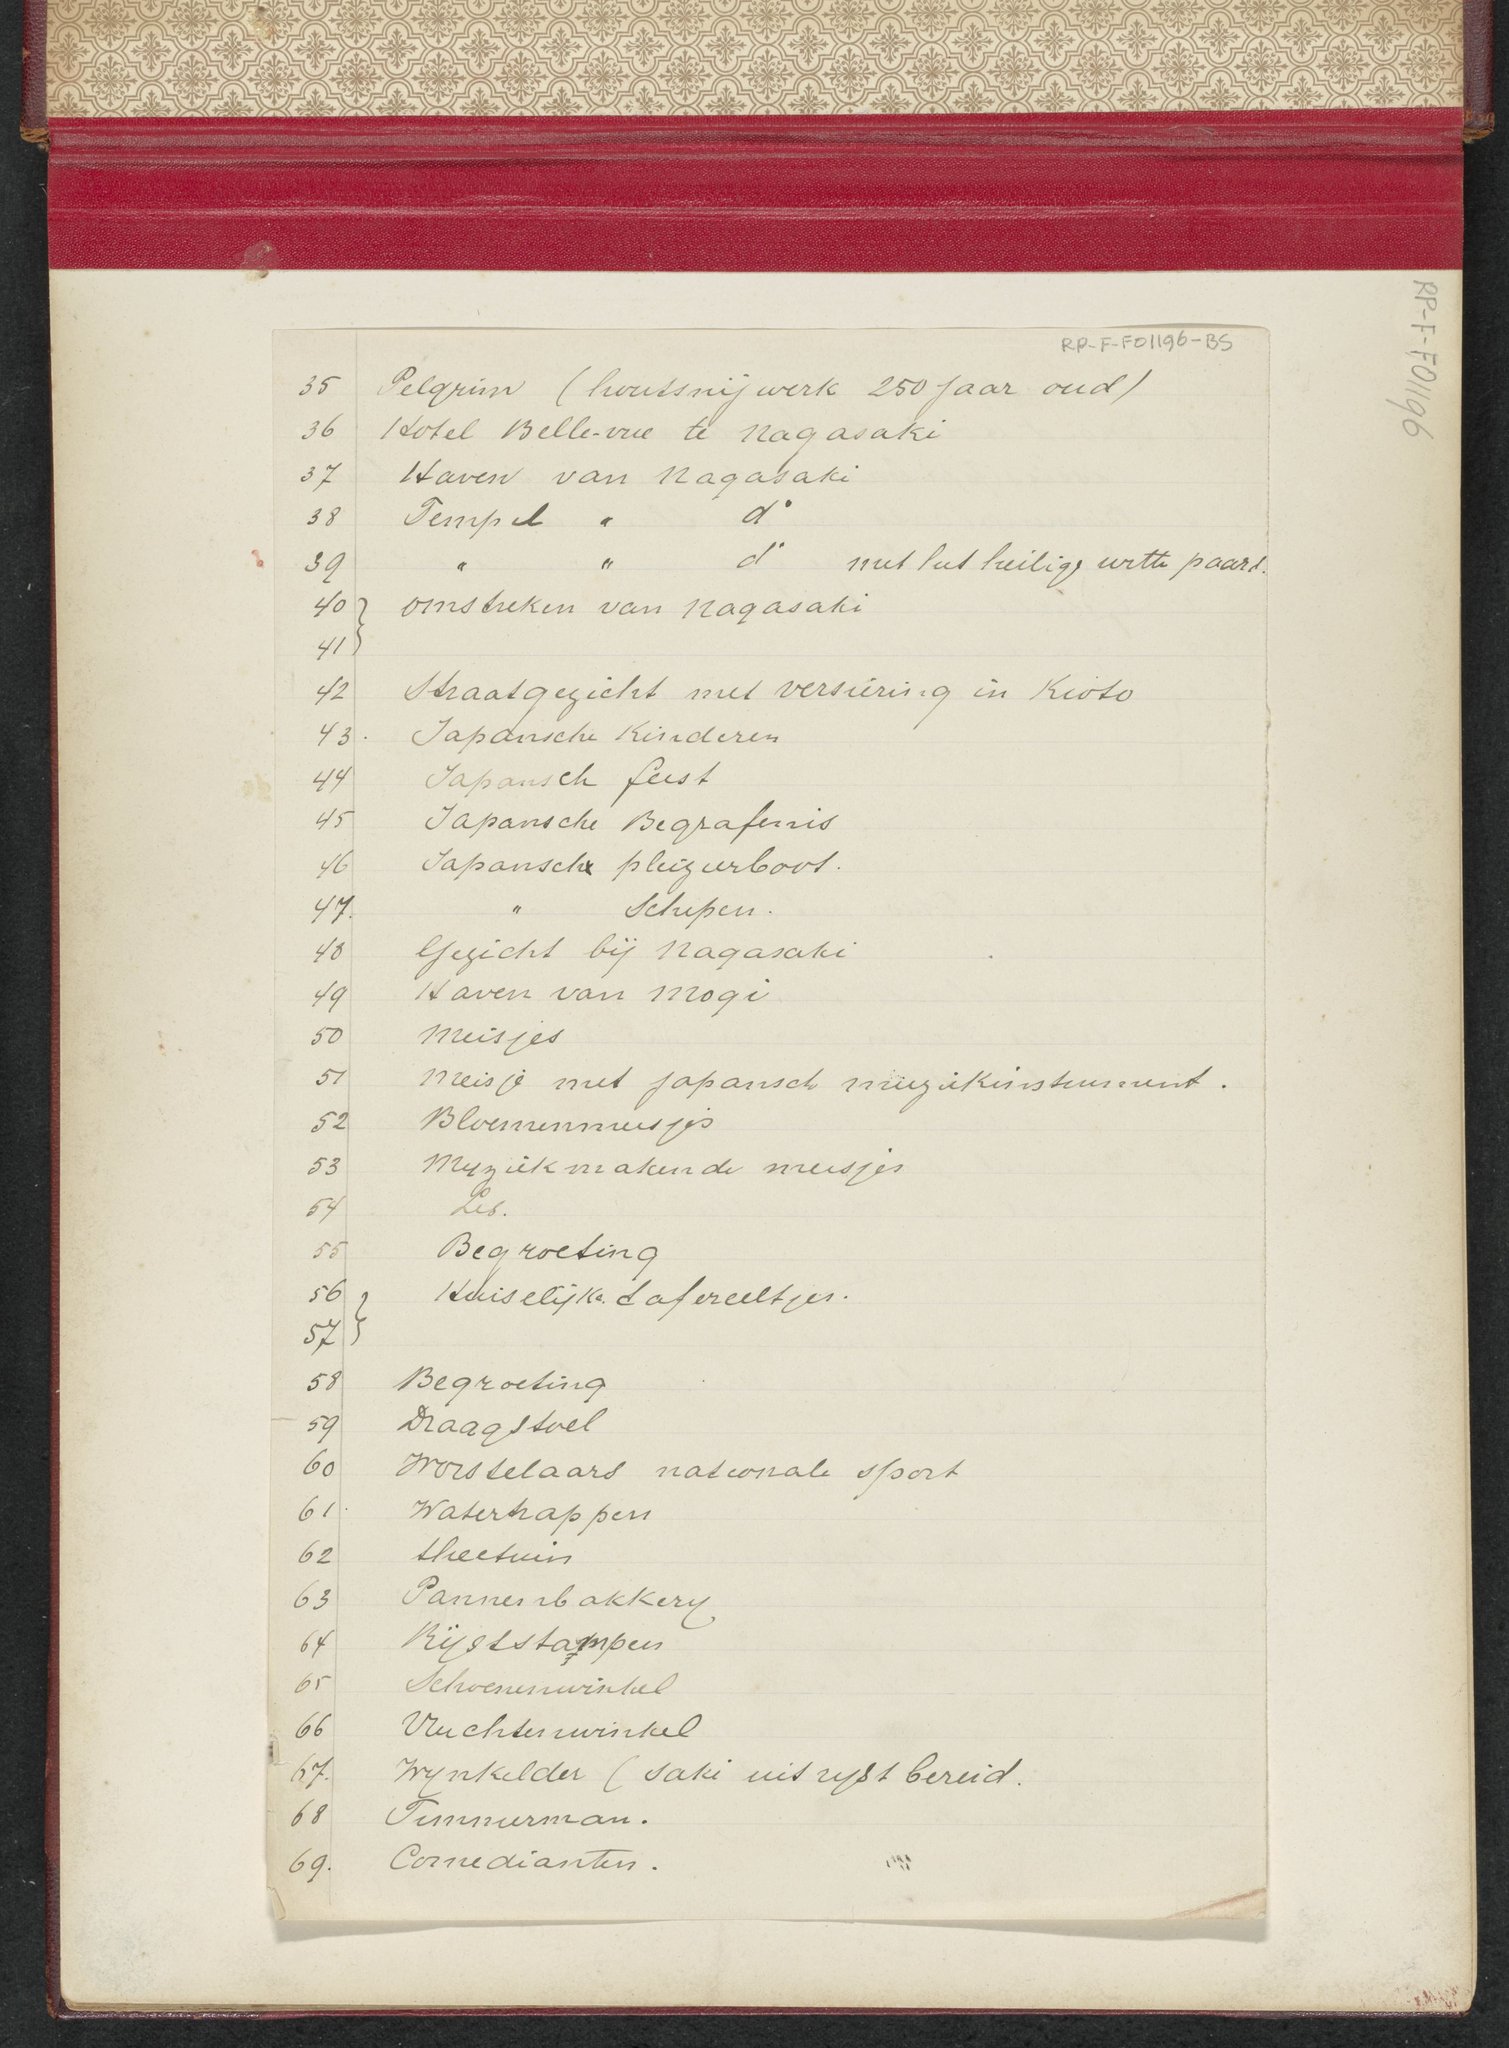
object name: list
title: Lijst met in het album afgebeelde onderwerpen (35 t/m 69)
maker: Anonymous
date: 1890-1894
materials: paper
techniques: writing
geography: netherlands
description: Onderdeel van Album met 69 foto's van een reis door Japan.